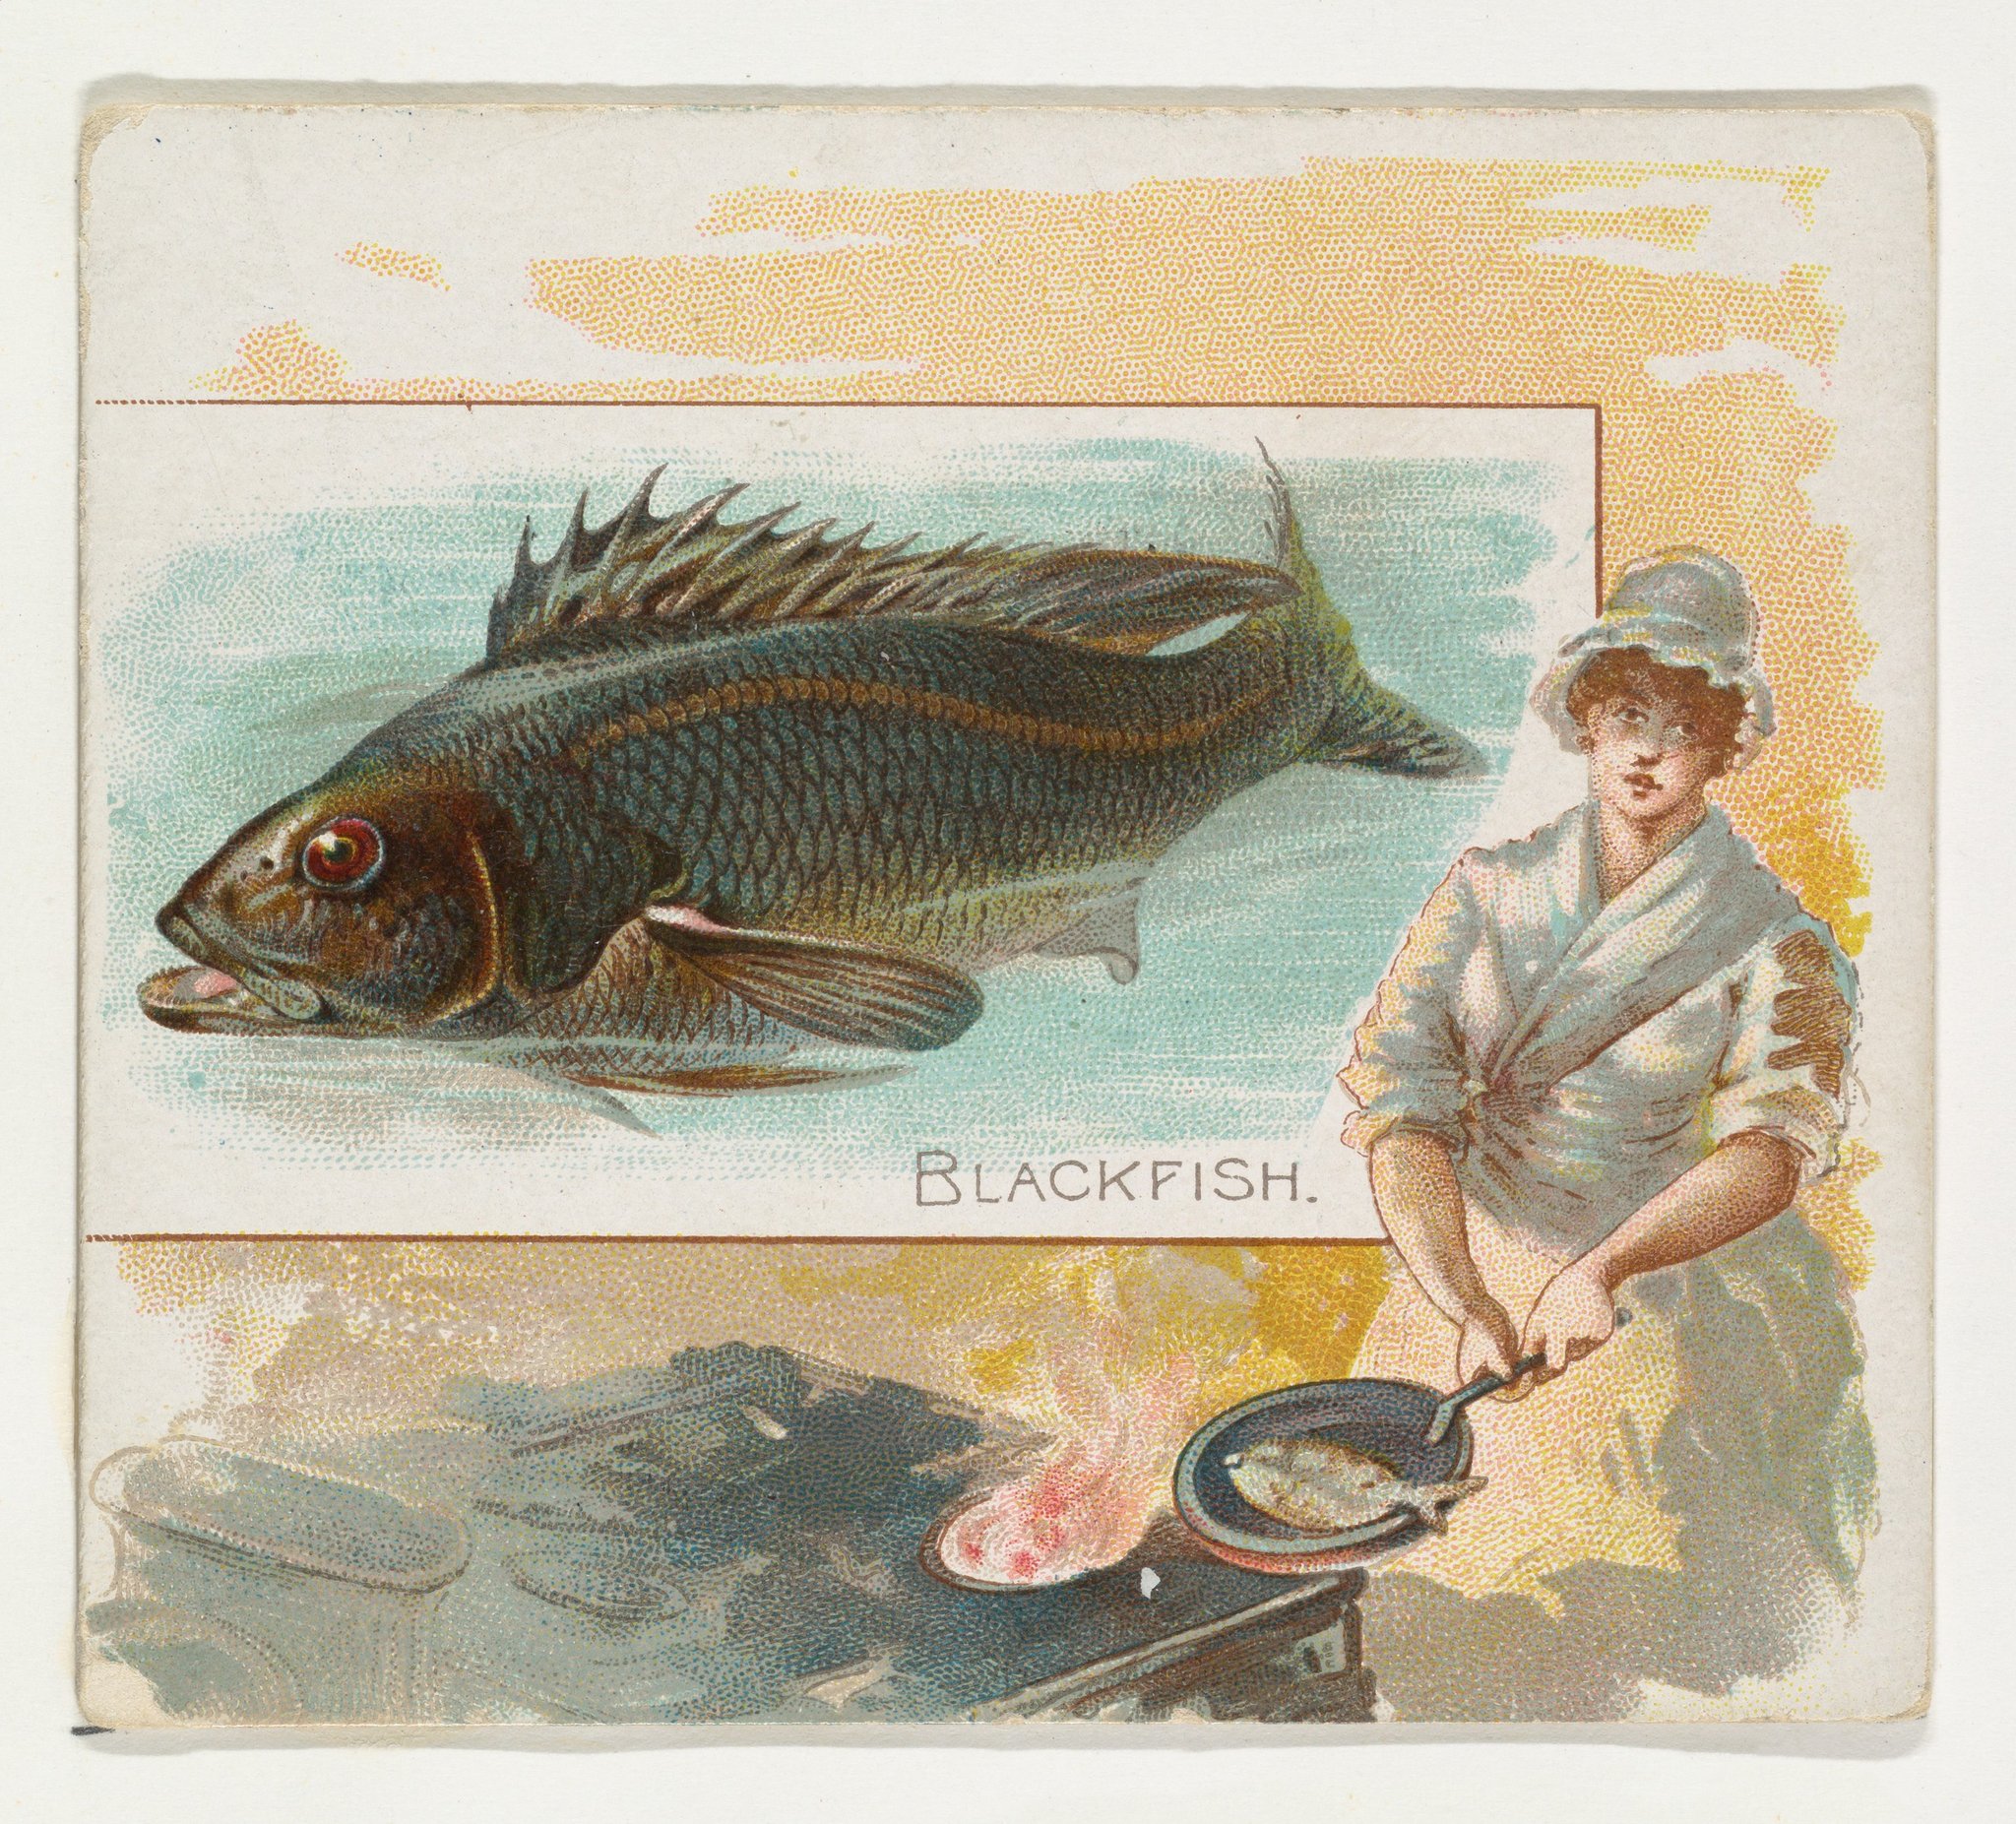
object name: print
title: Blackfish, from Fish from American Waters series (N39) for Allen & Ginter Cigarettes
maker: allen & ginter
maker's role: publisher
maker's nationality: american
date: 1889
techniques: color lithograph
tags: fish